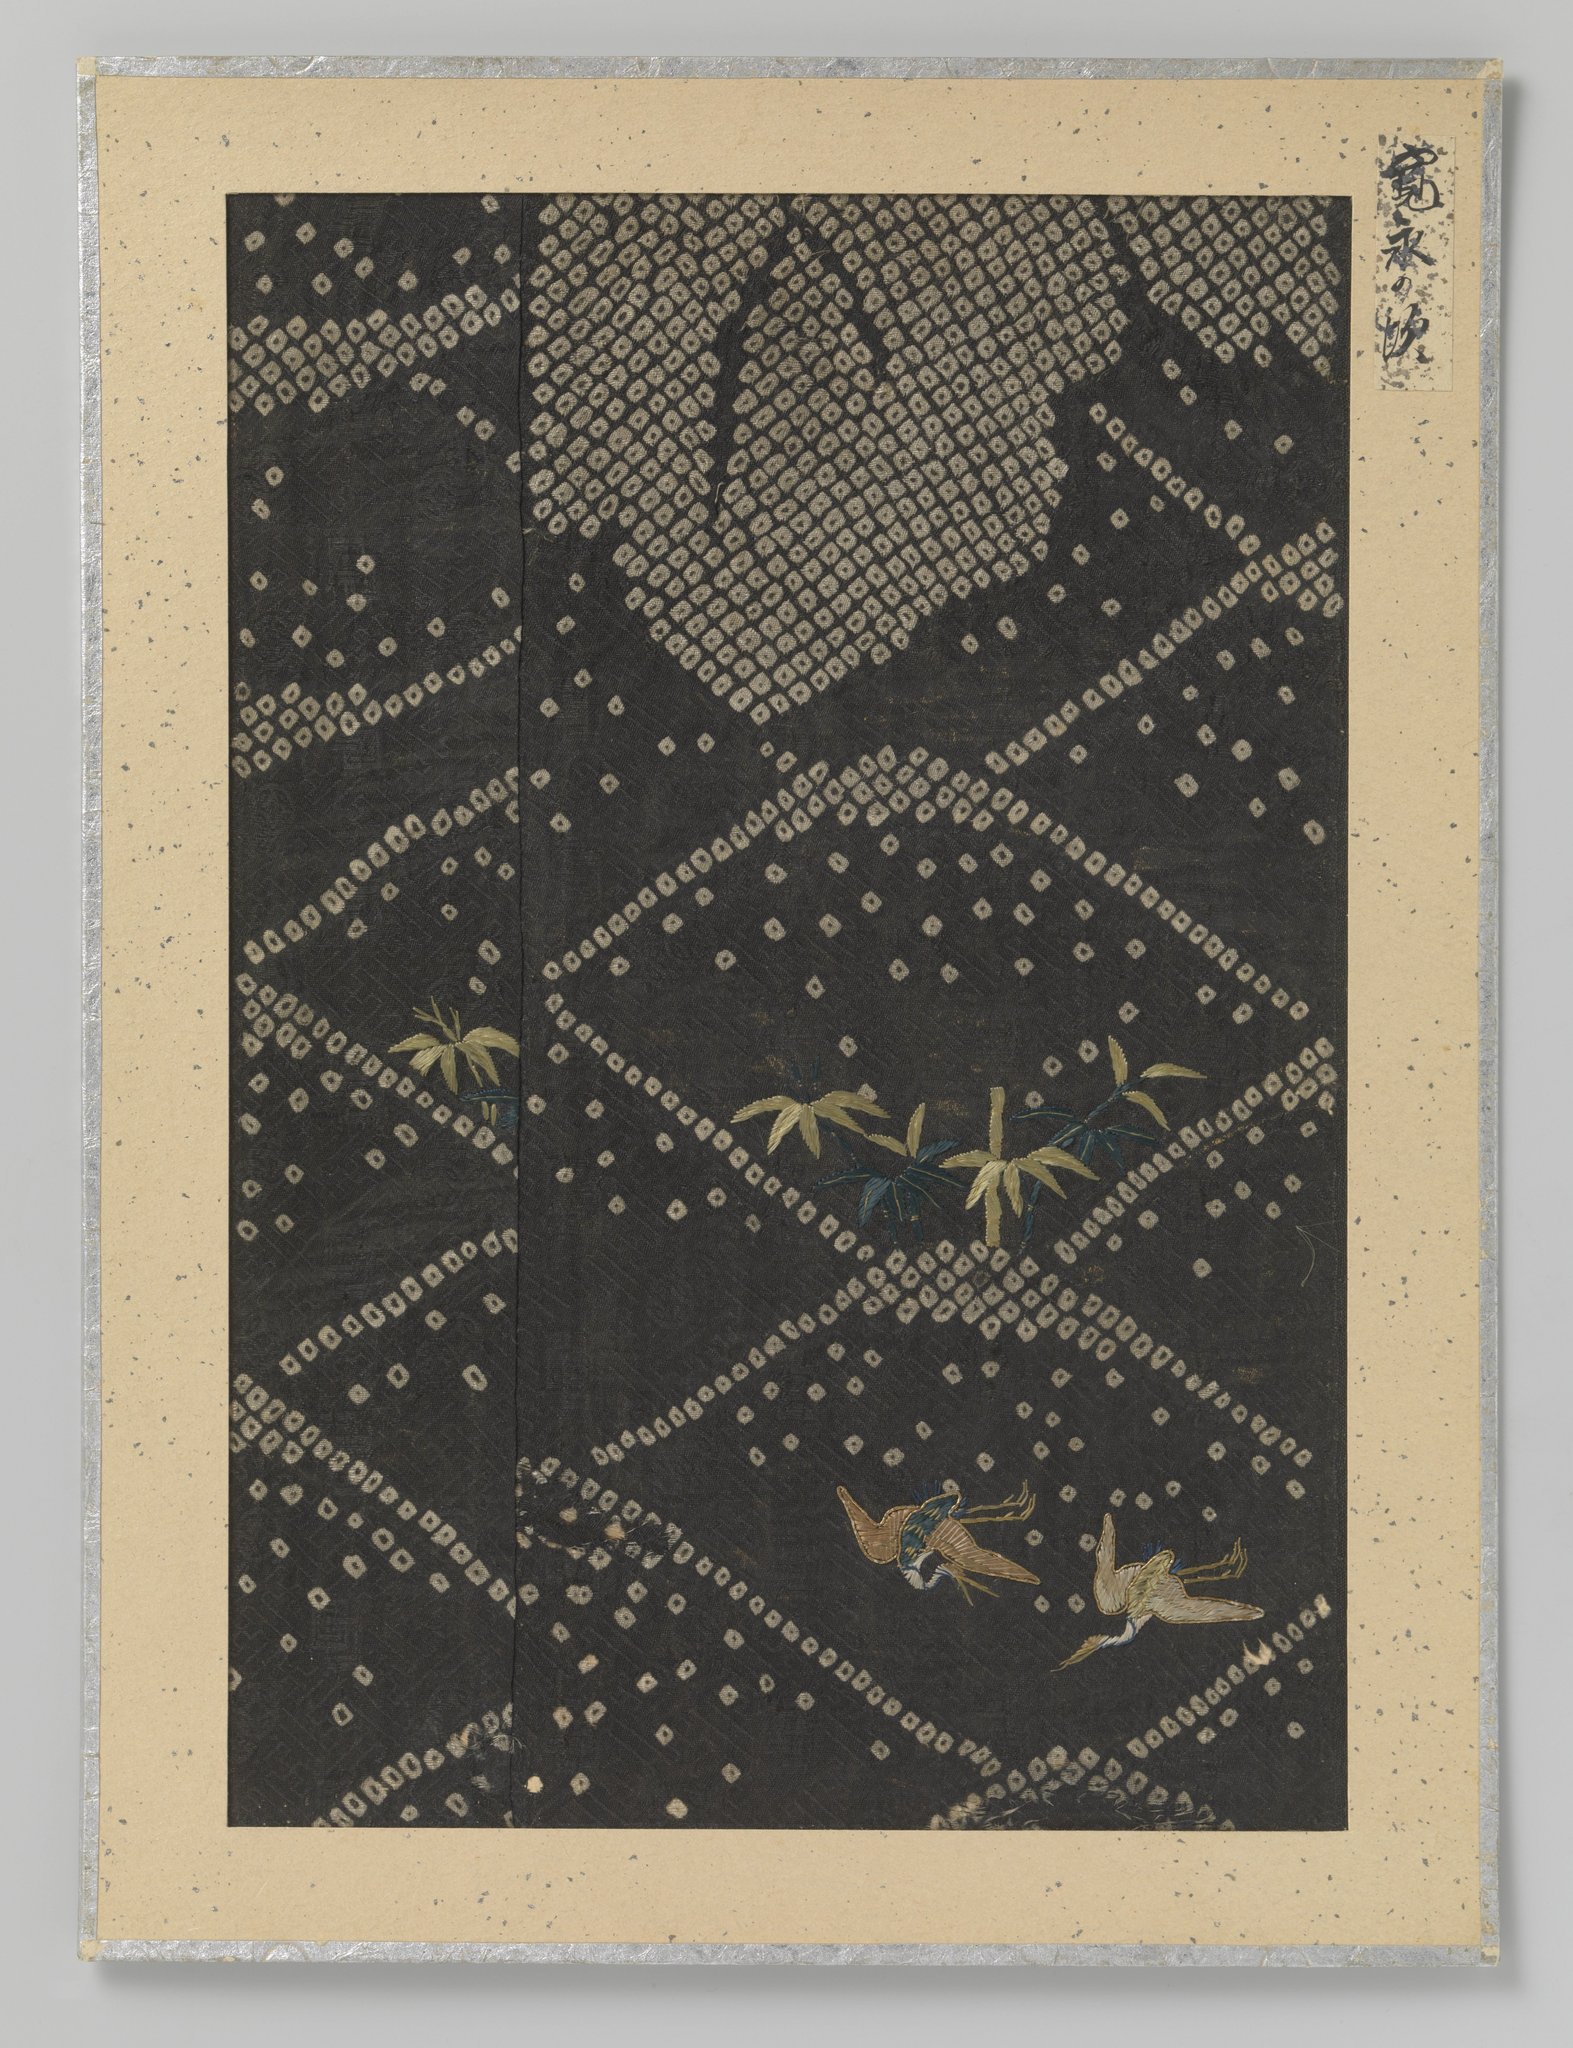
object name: fragment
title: Fragment textiel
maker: Anonymous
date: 1624-1643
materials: silk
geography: japan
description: Textielfragment, geometrische motieven en borduursel op zwarte zijden damast.